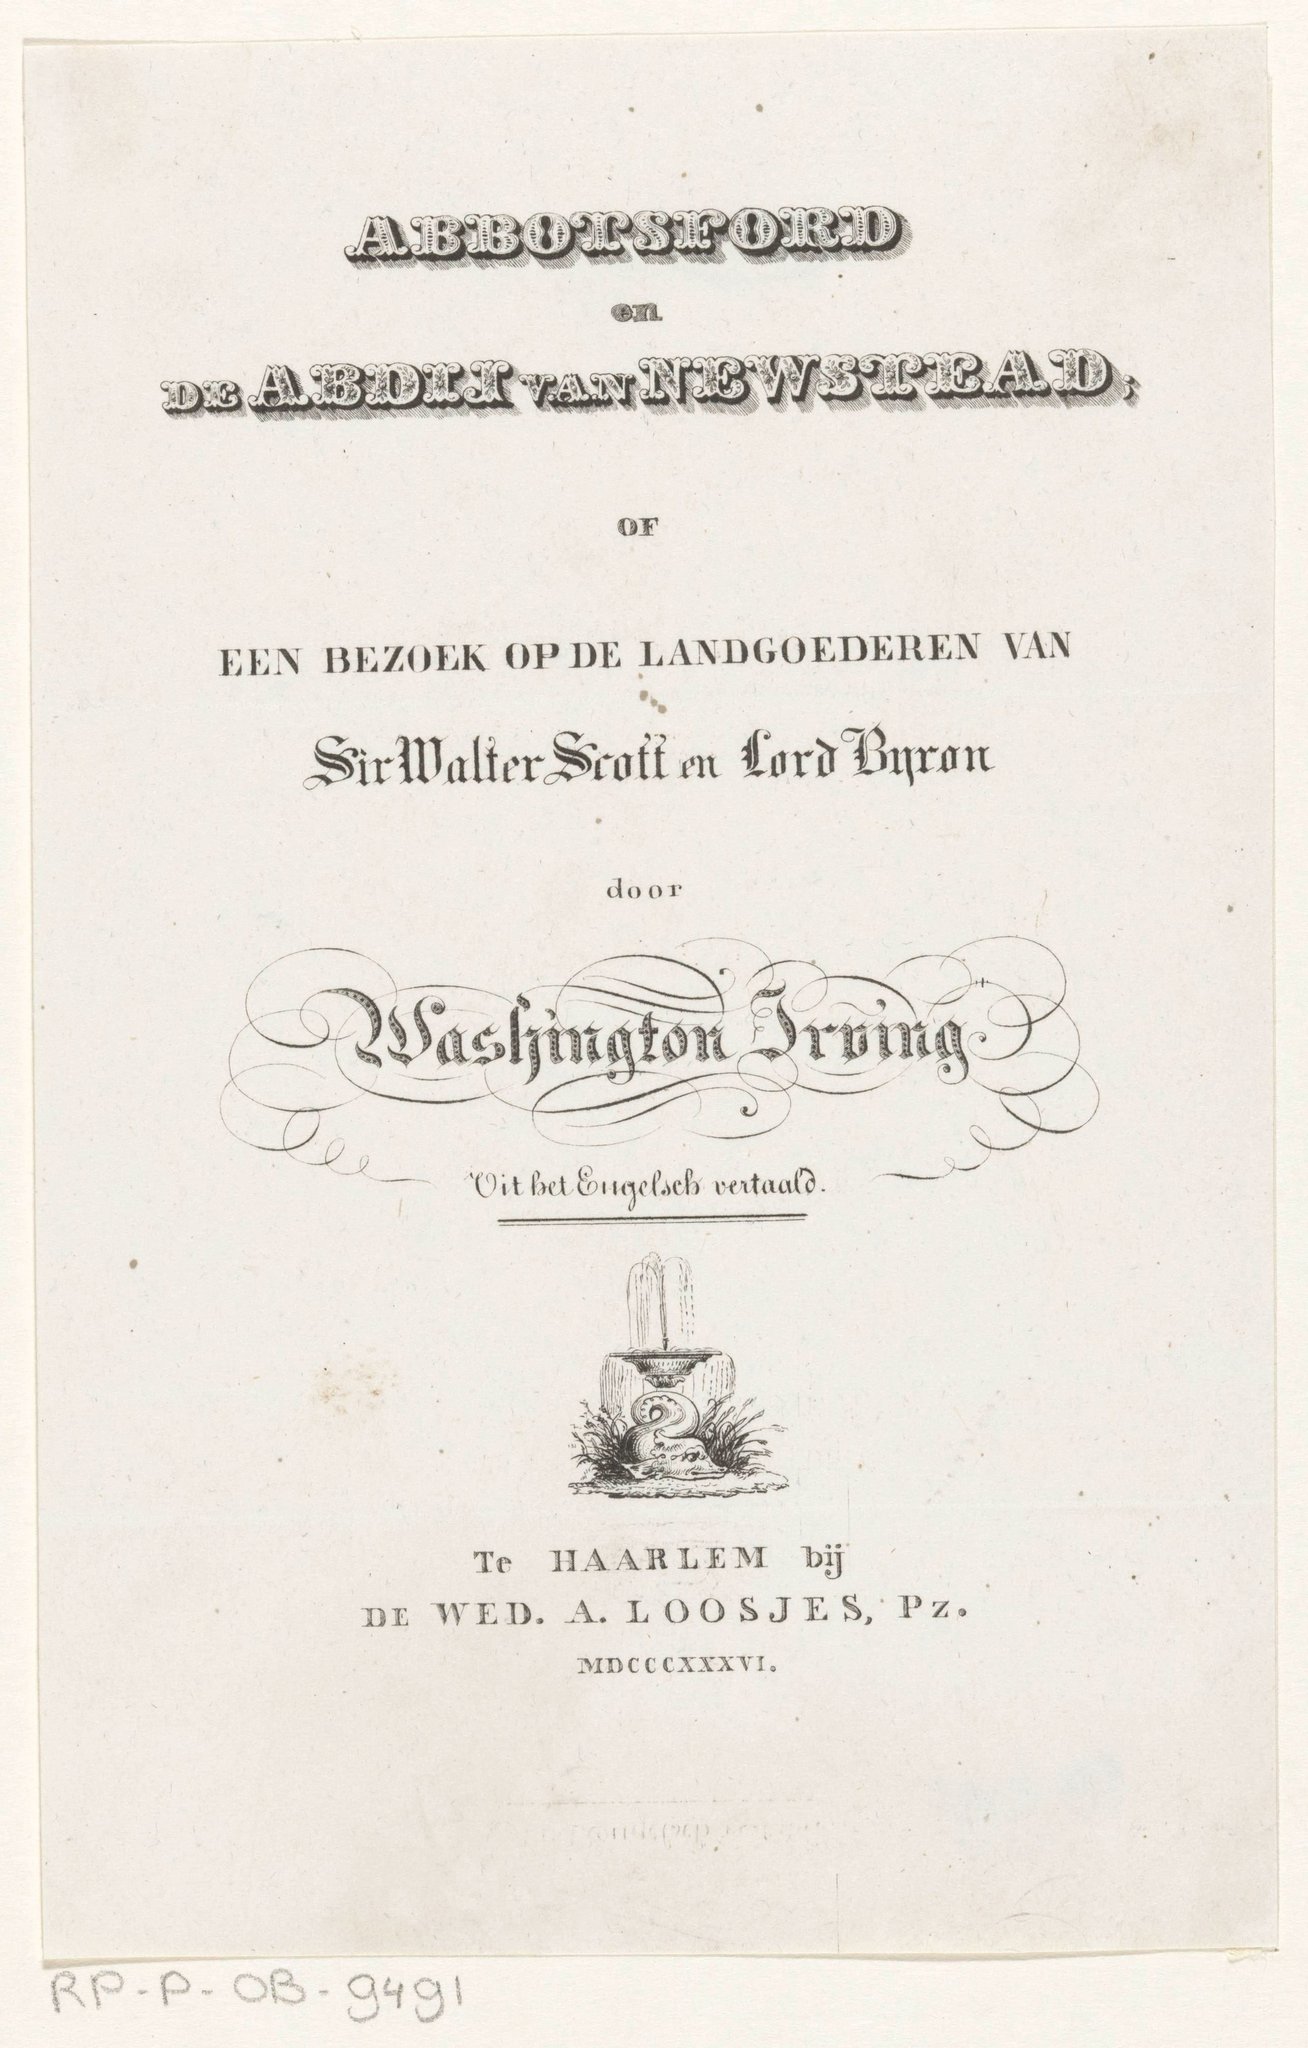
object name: titelblad, titelpagina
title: Fontein met dolfijn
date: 1836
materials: paper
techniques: engraving, etching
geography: haarlem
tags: dolphin ~ ornament, ornamental fountain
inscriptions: collector's mark: Lugt 2228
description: Titelpagina voor: Irving, Washington. Abbotsford en de abdy van Newstead, of een bezoek op de landgoederen van Sir Walter Scott en Lord Byron. Haarlem: Loosjes Pz., weduwe Adriaan, 1836.